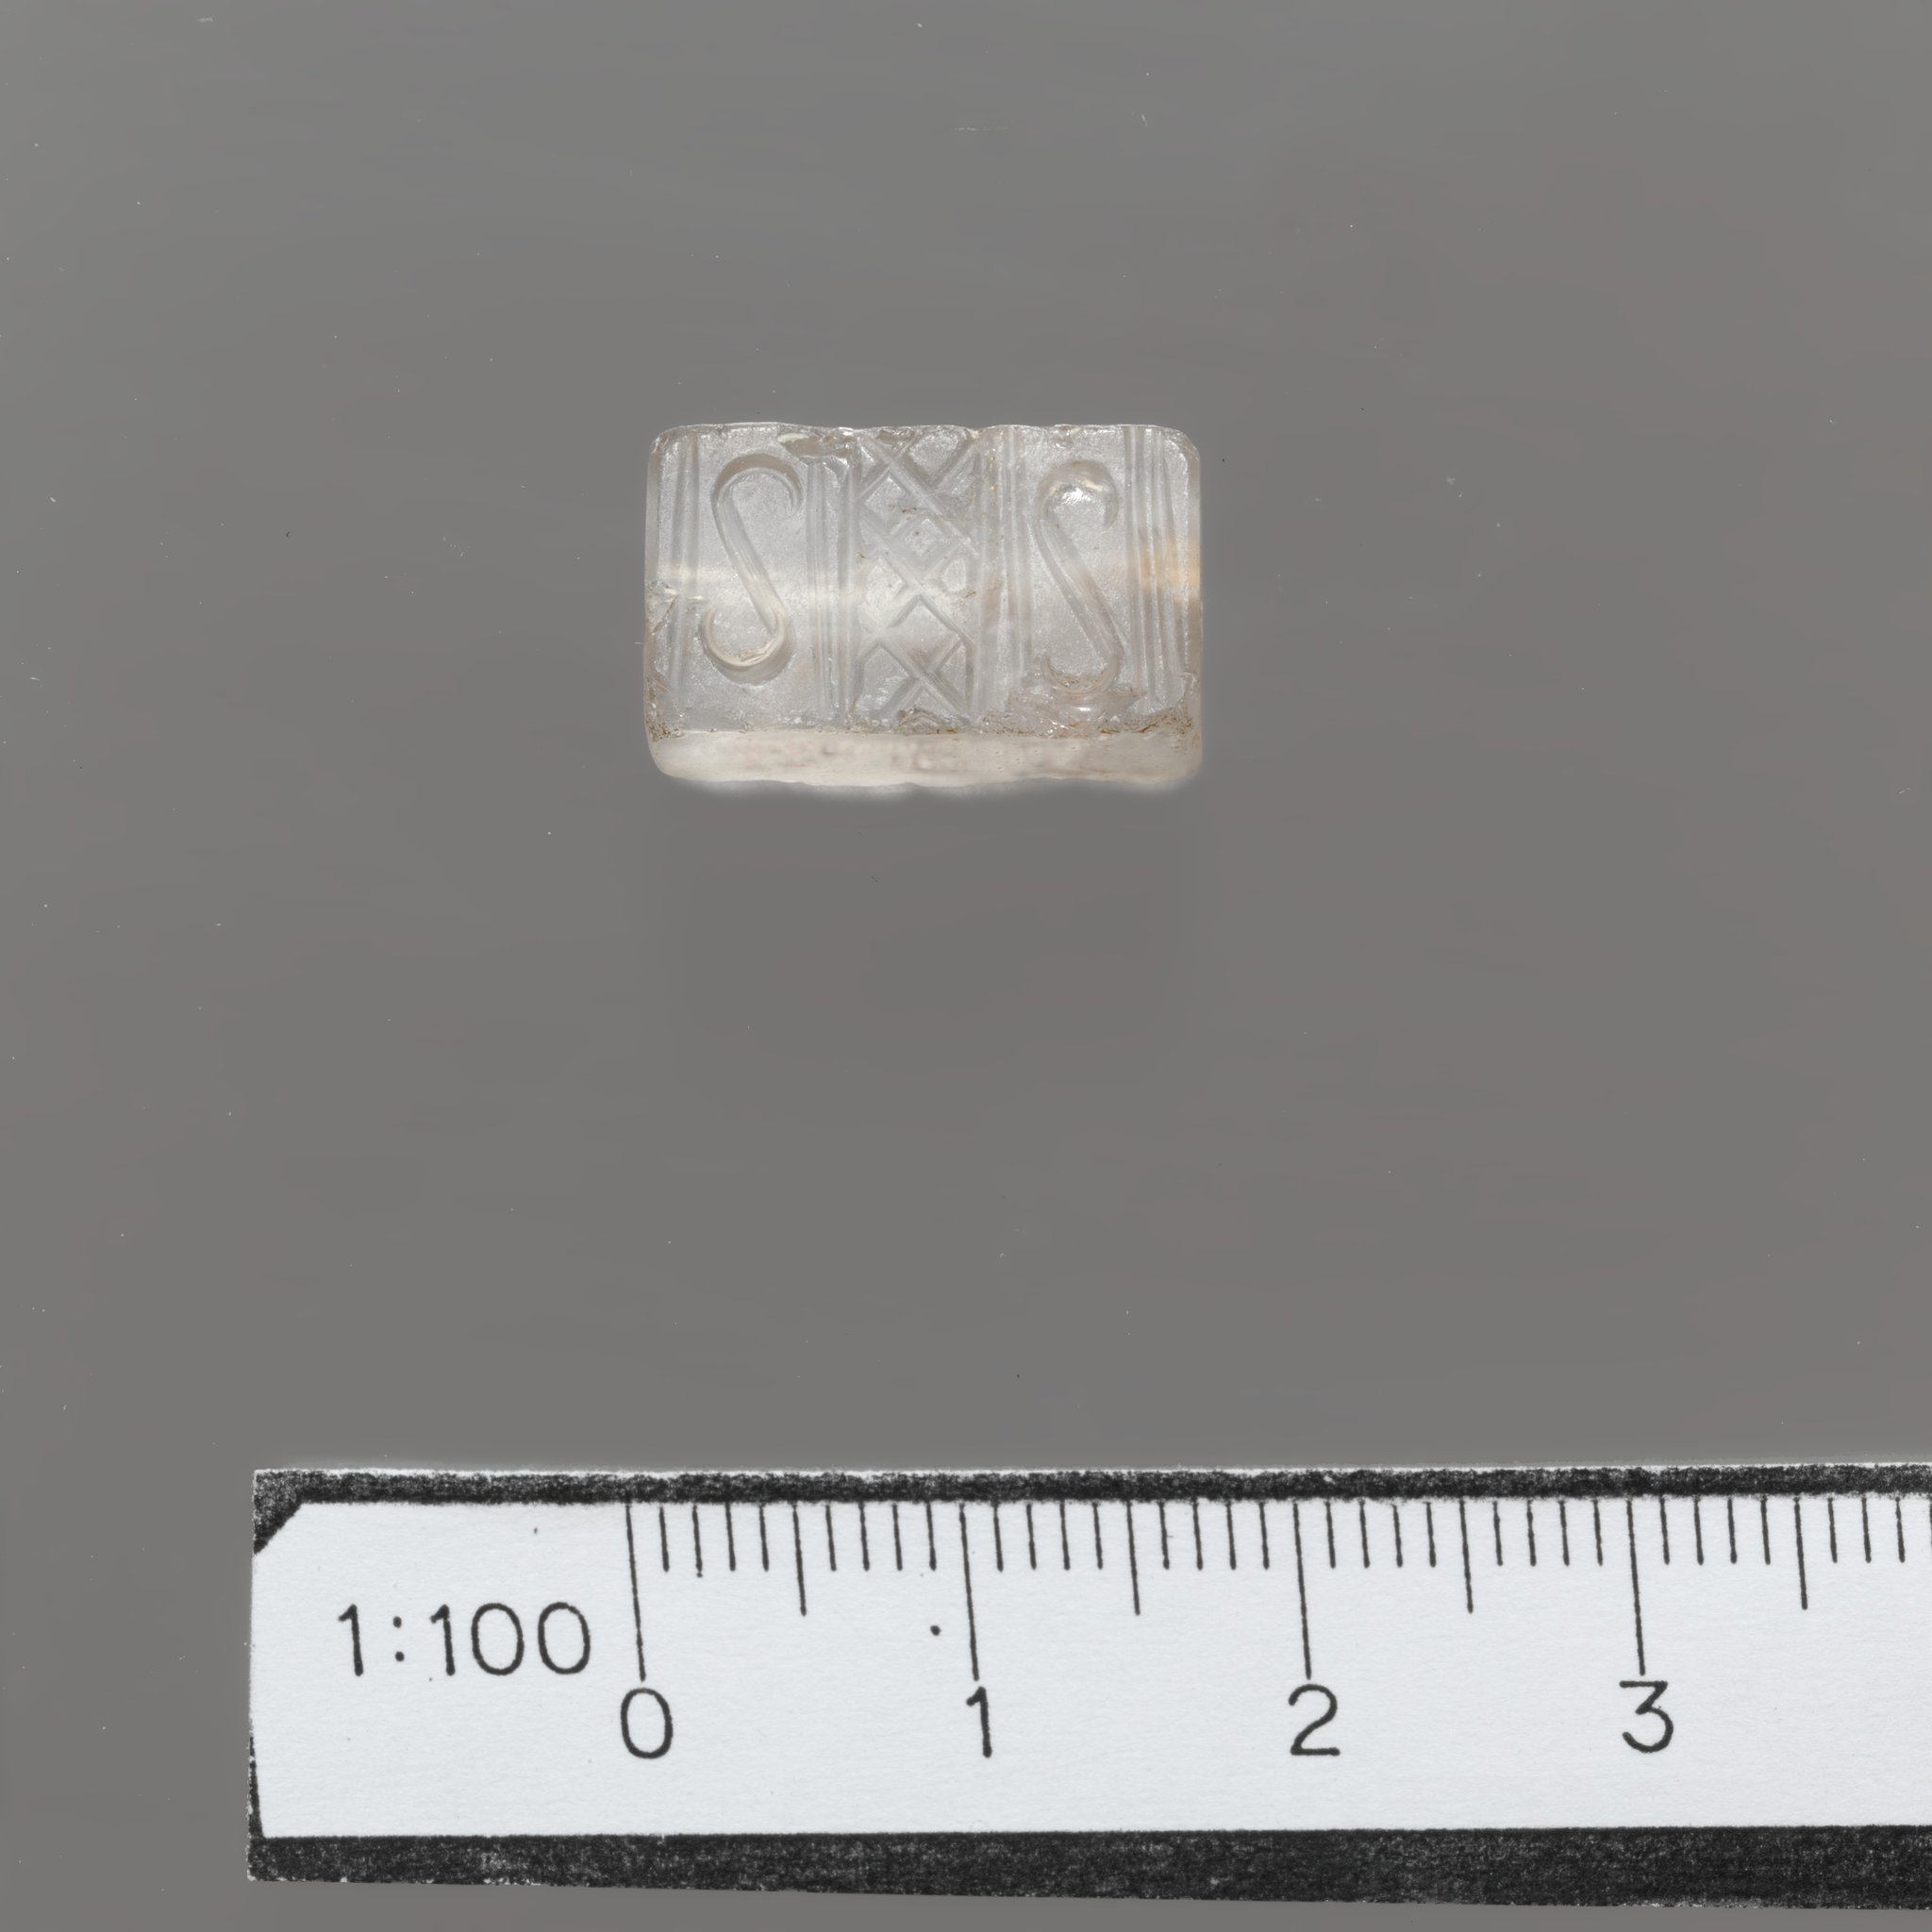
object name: prism, rectangular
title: Rock crystal rectangular prism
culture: minoan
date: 1900-1600 BCE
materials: quartz